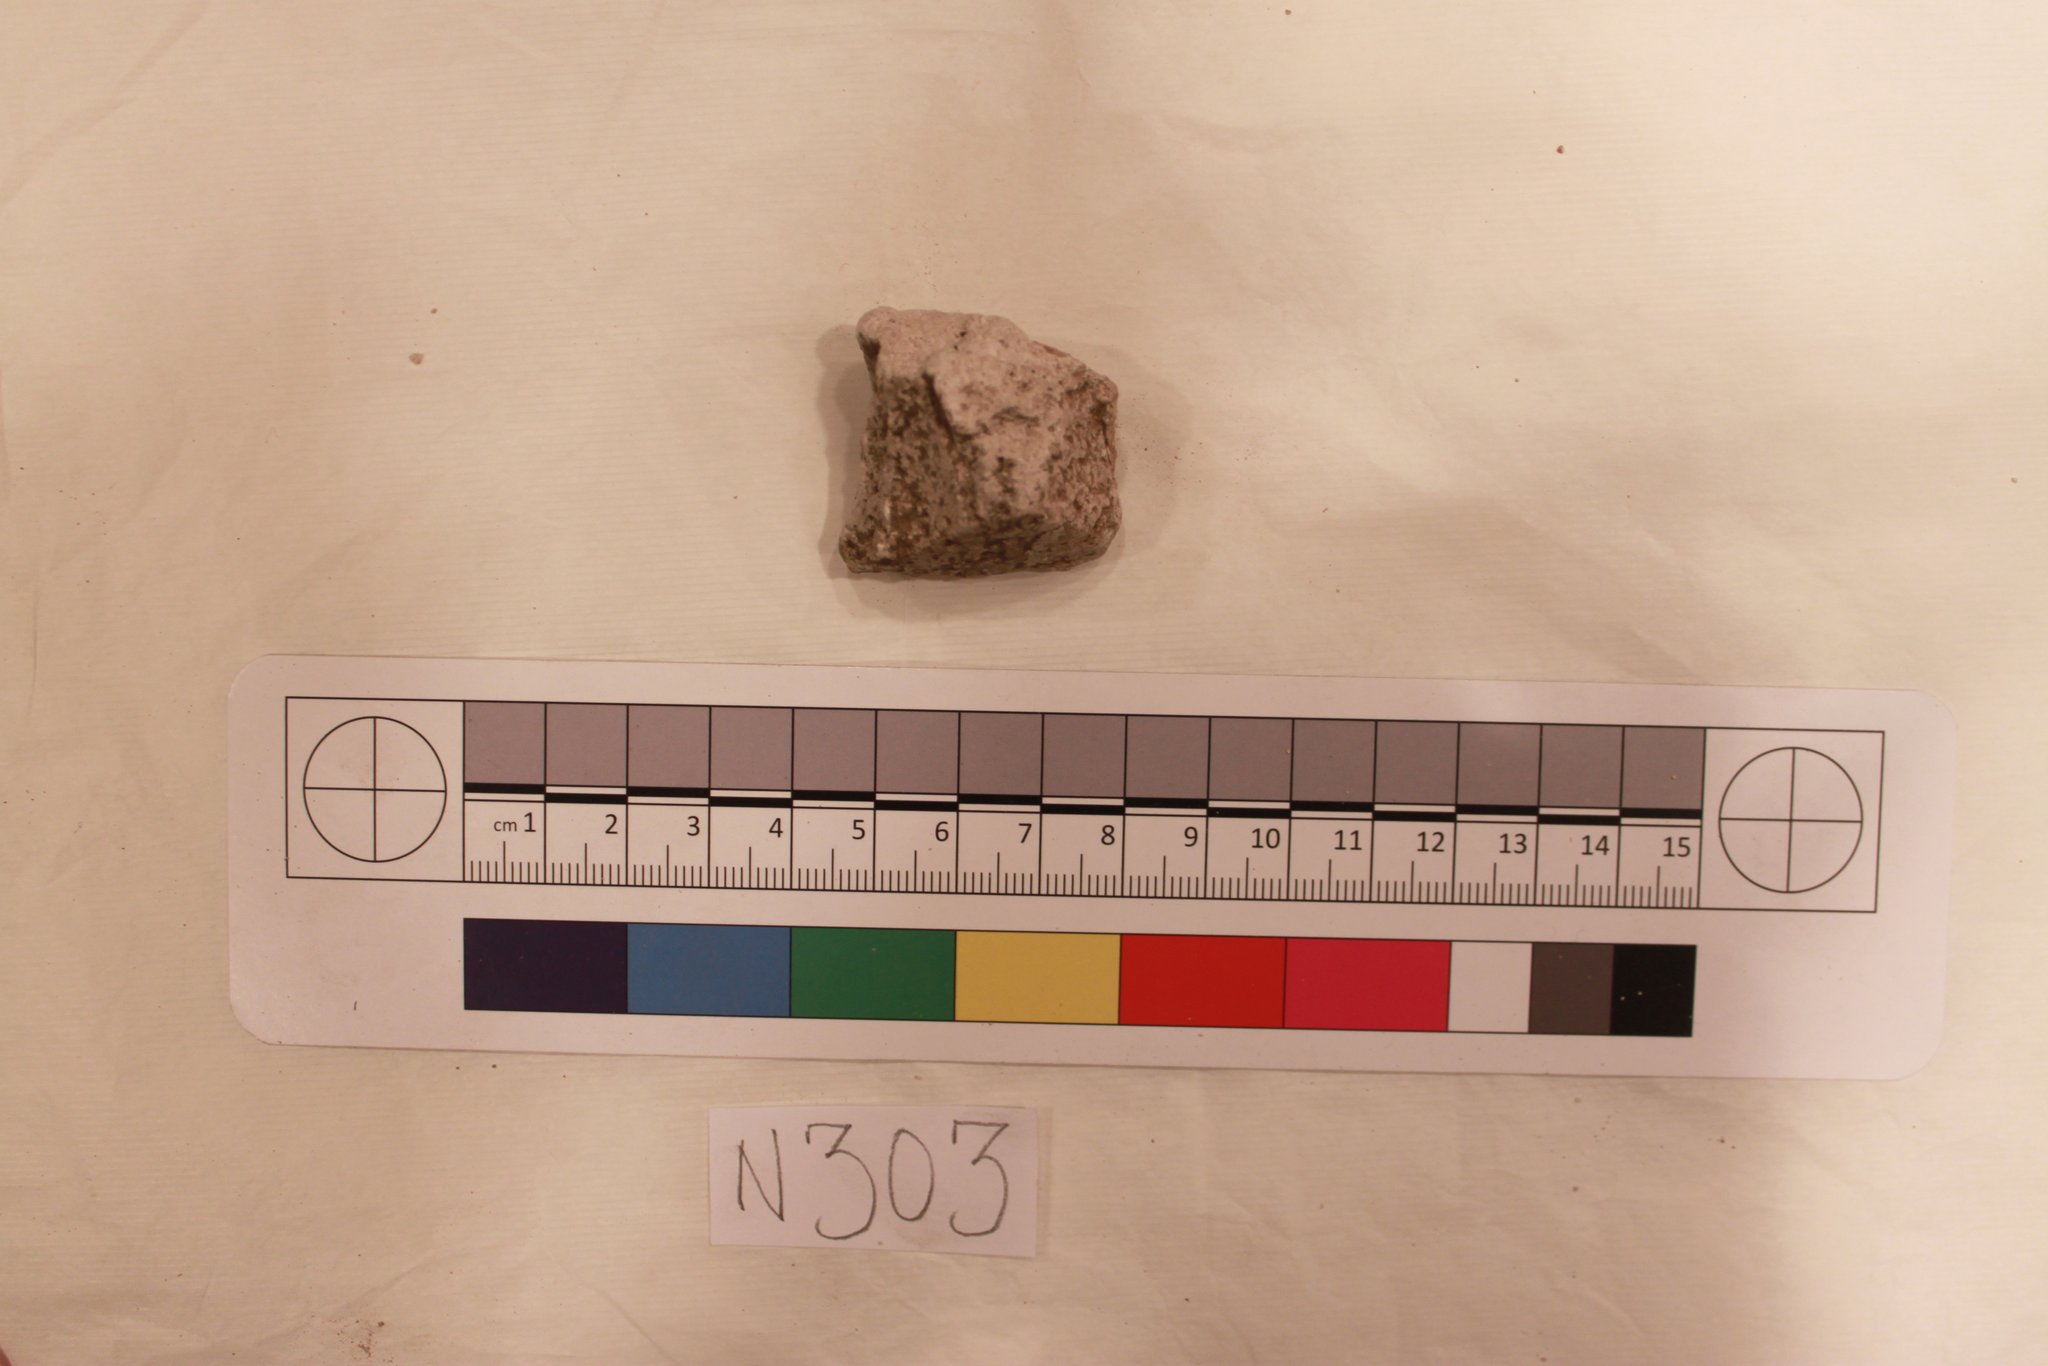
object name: fragment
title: Stucco Fragment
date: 701-1200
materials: plaster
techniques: carving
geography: iran